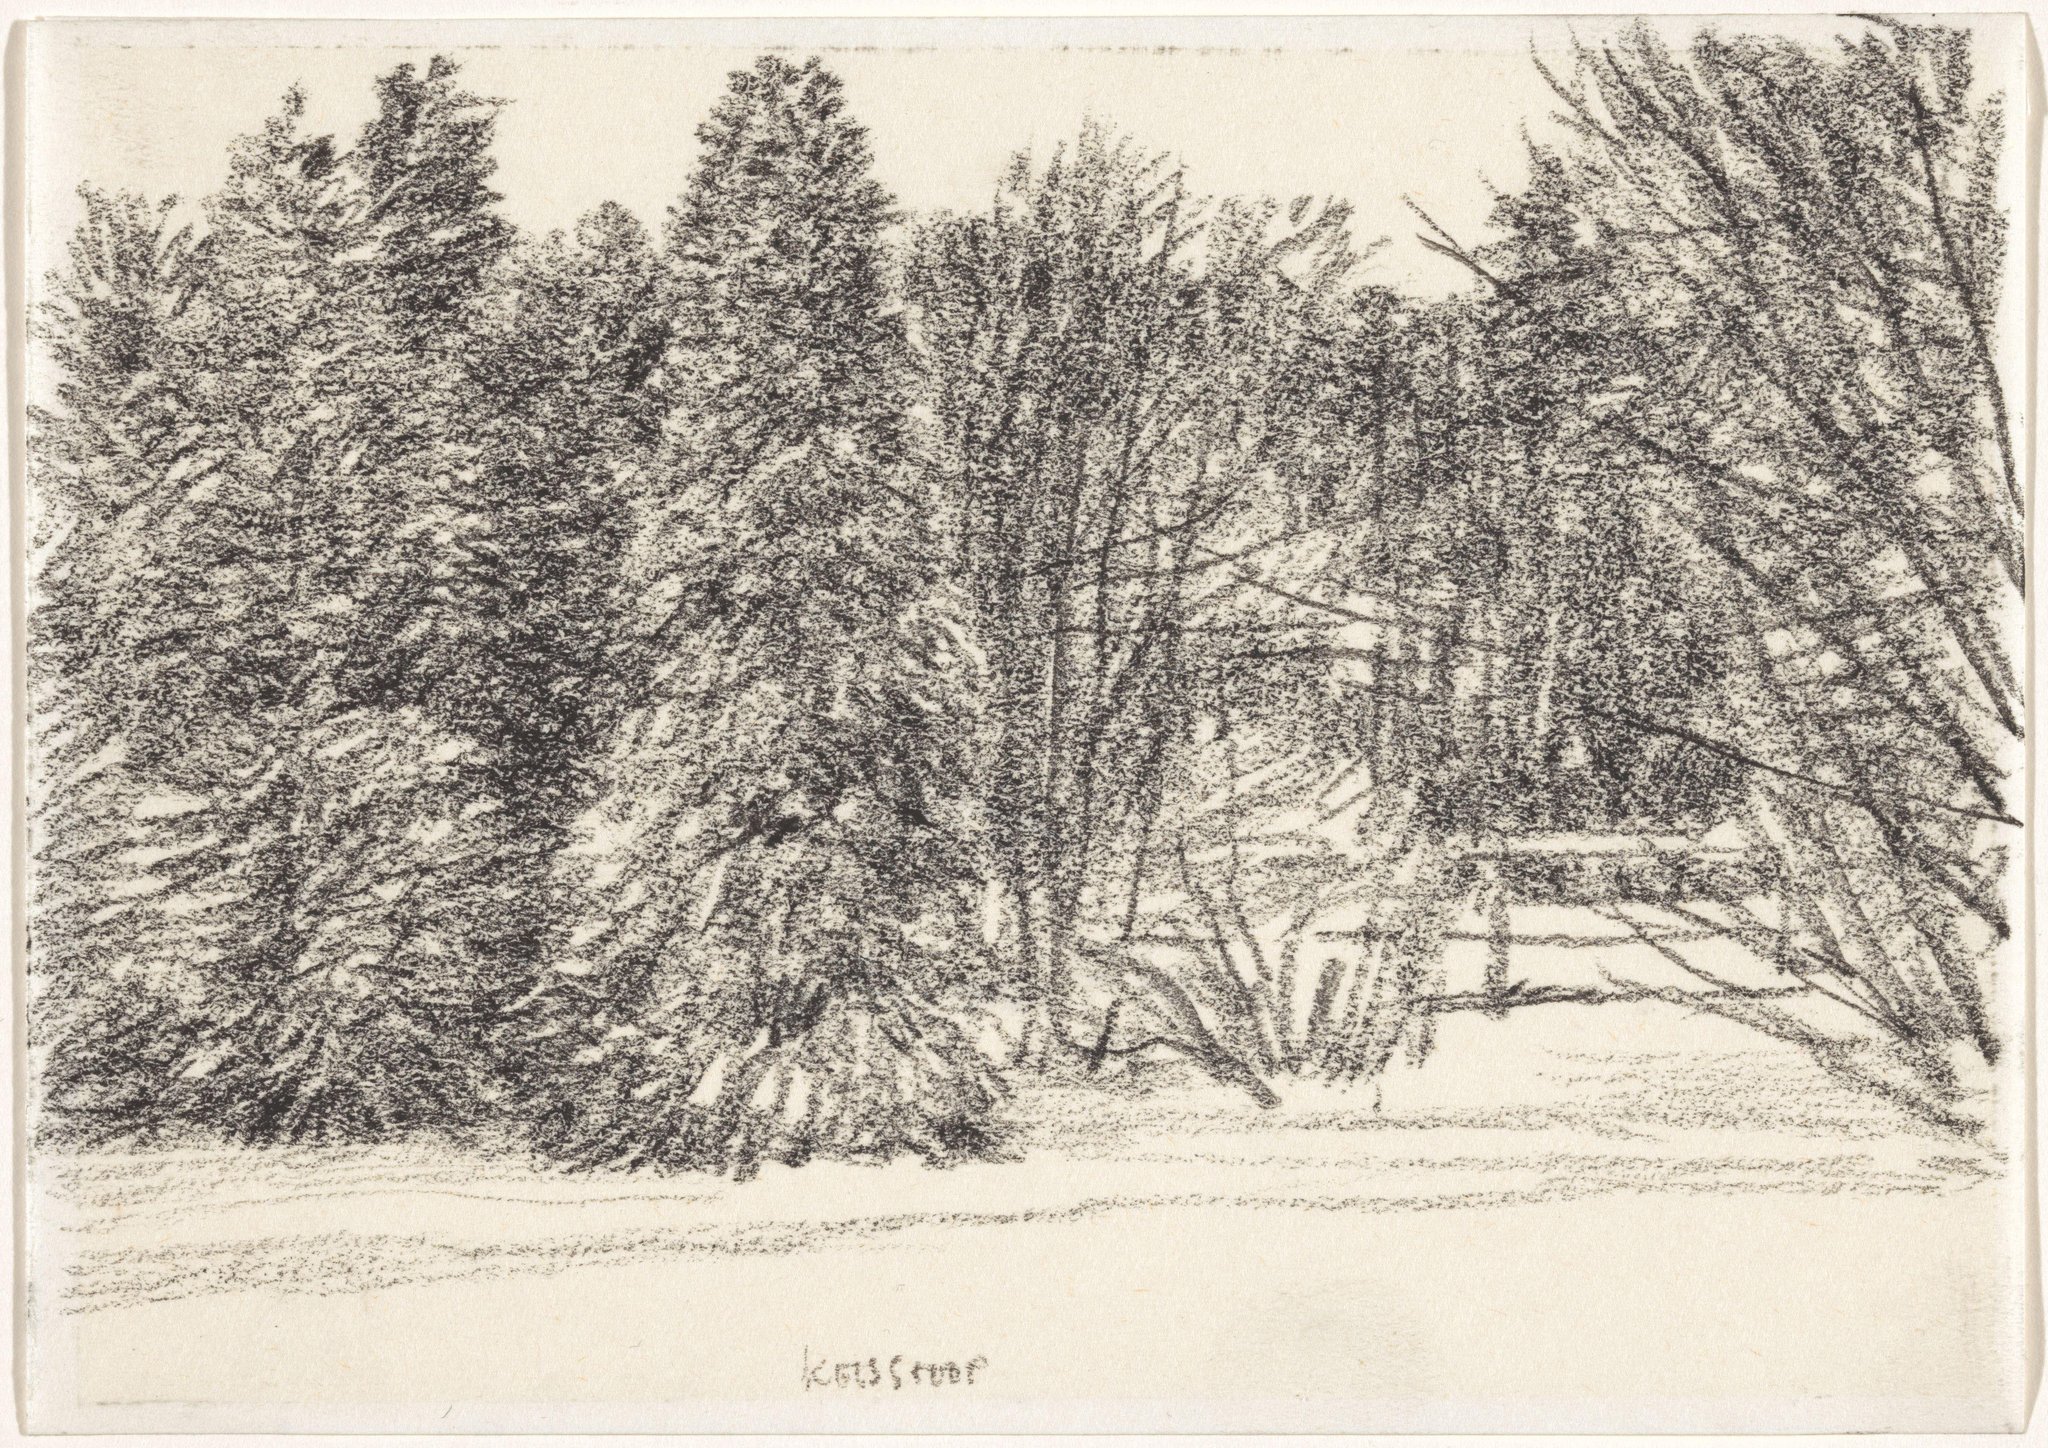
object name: drawing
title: Bosrand met naaldbomen en struikgewas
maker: kees stoop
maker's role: draughtsman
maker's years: 1929-2019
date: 1939-2009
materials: charcoal, paper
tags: fringe, edge of the wood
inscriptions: signature: ‘Kees Stoop’